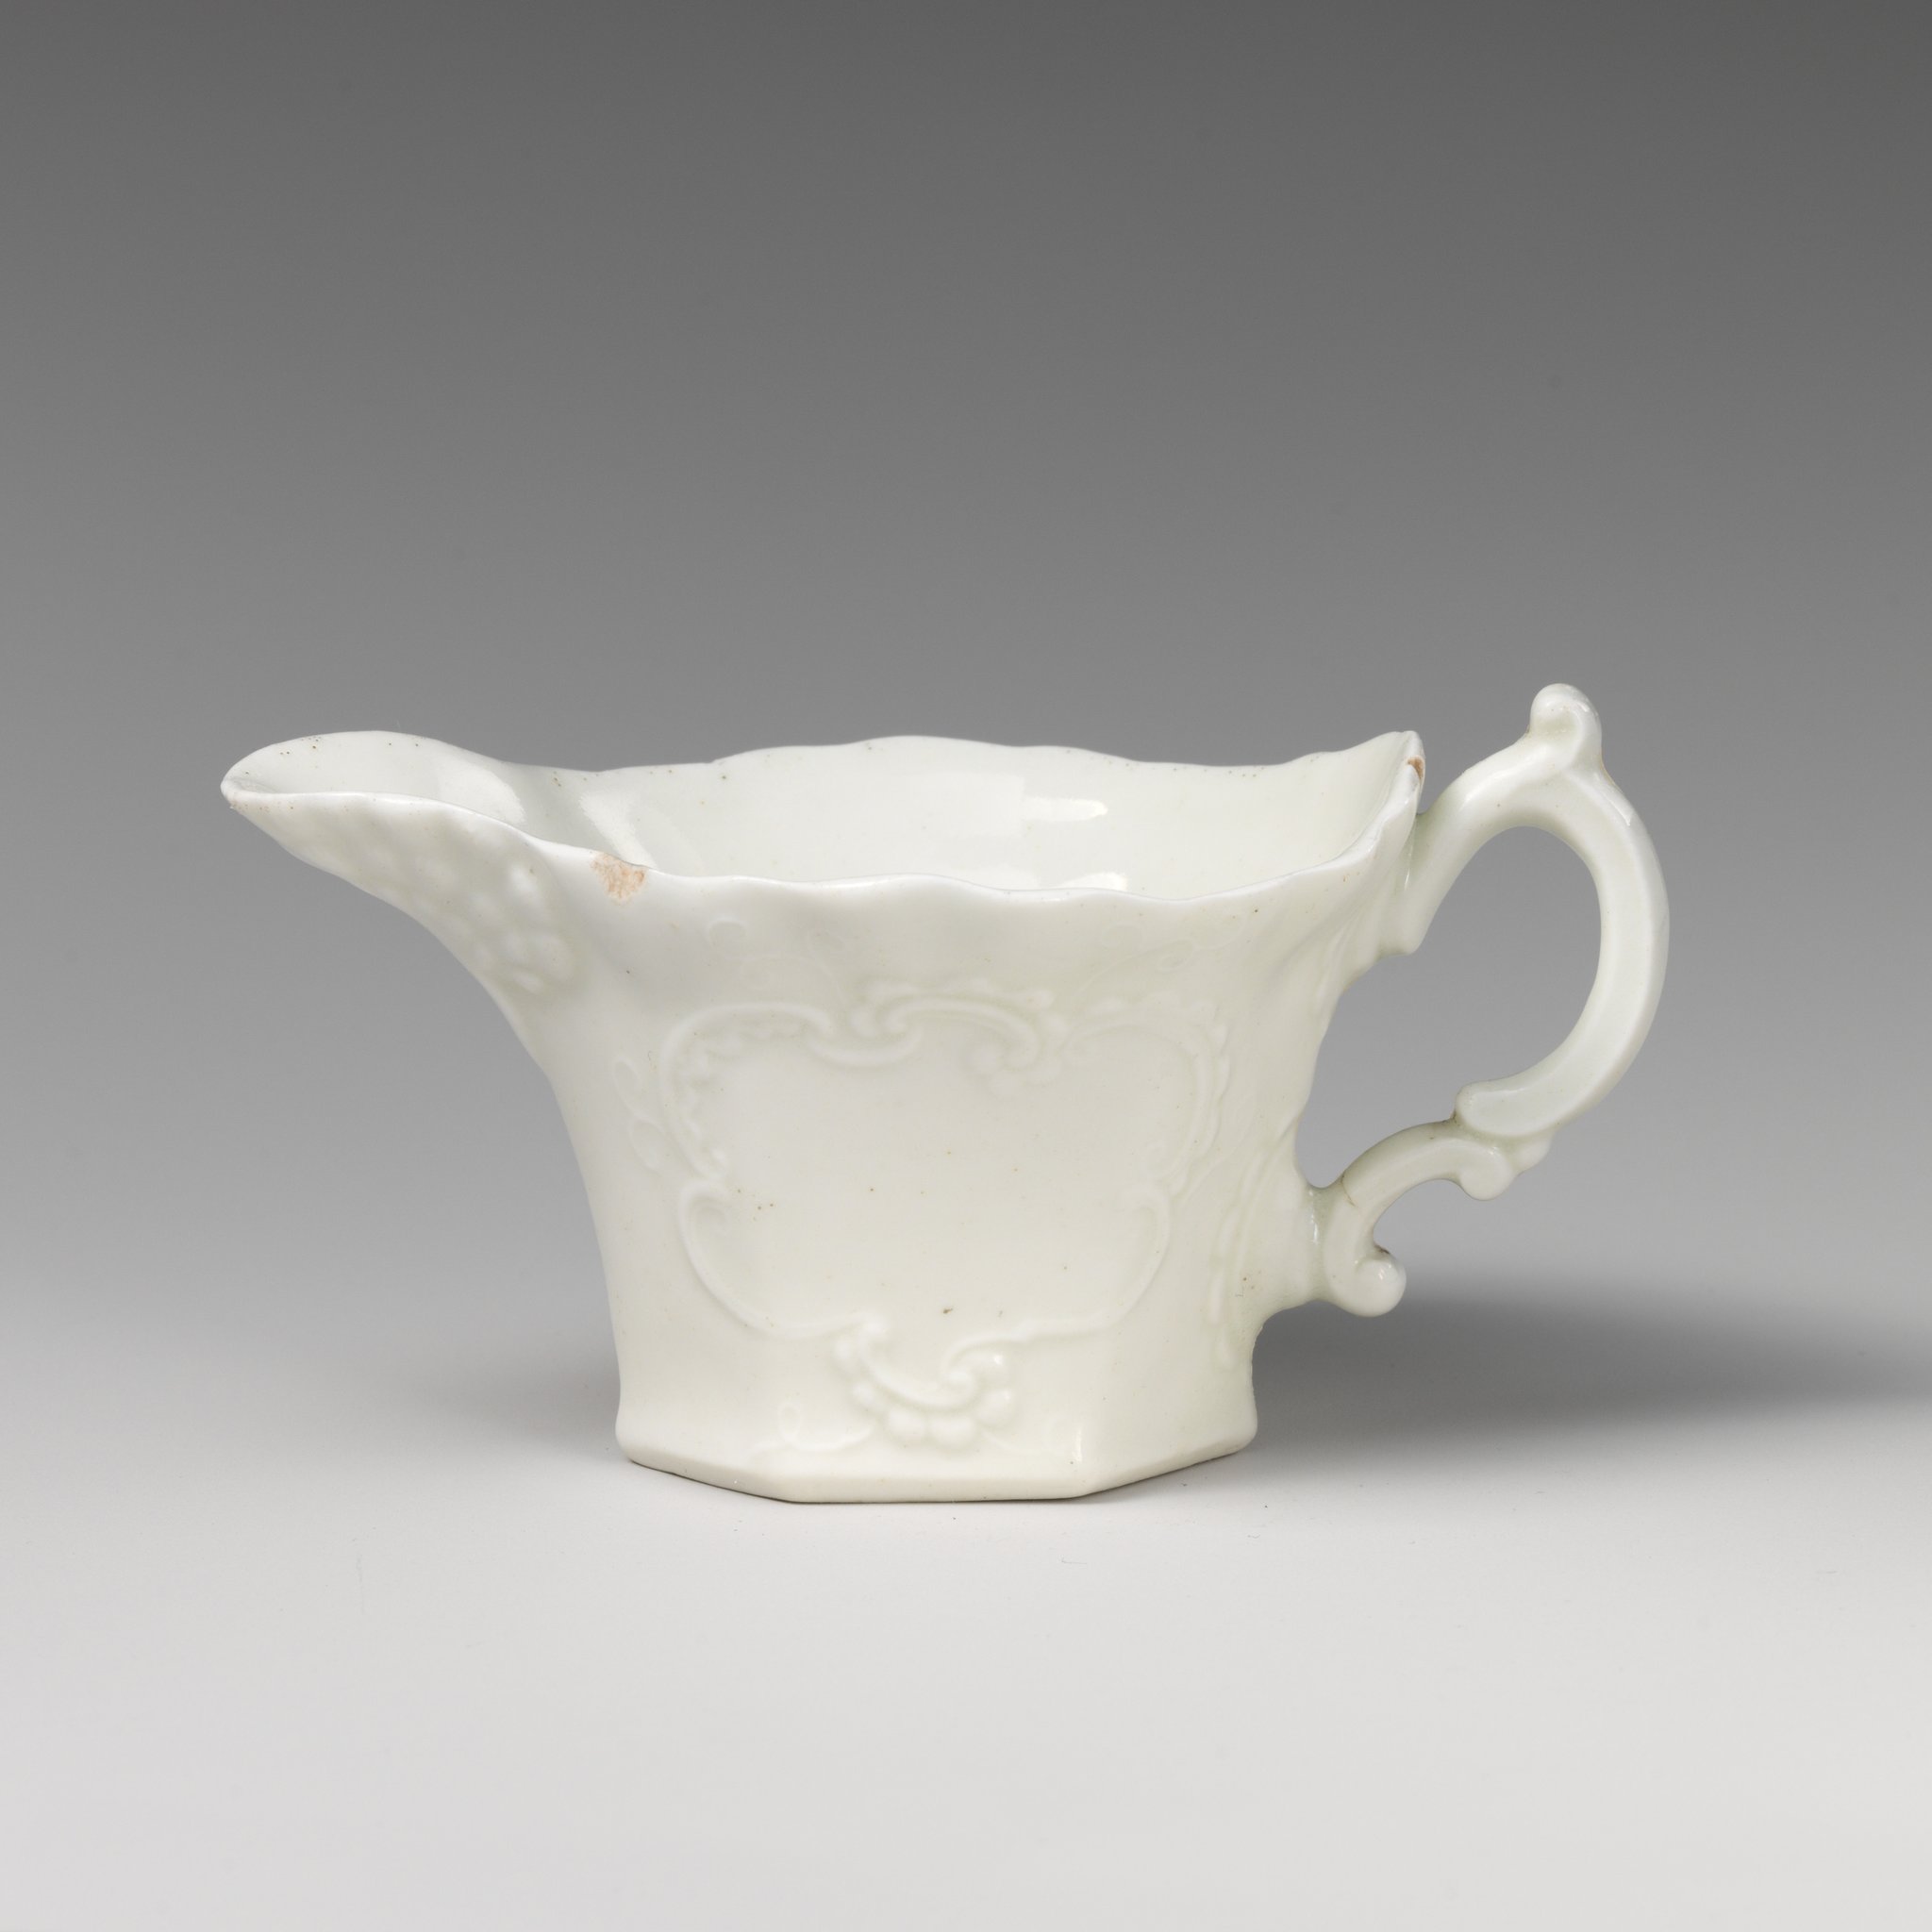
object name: jug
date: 1701-1800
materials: soft paste porcelain